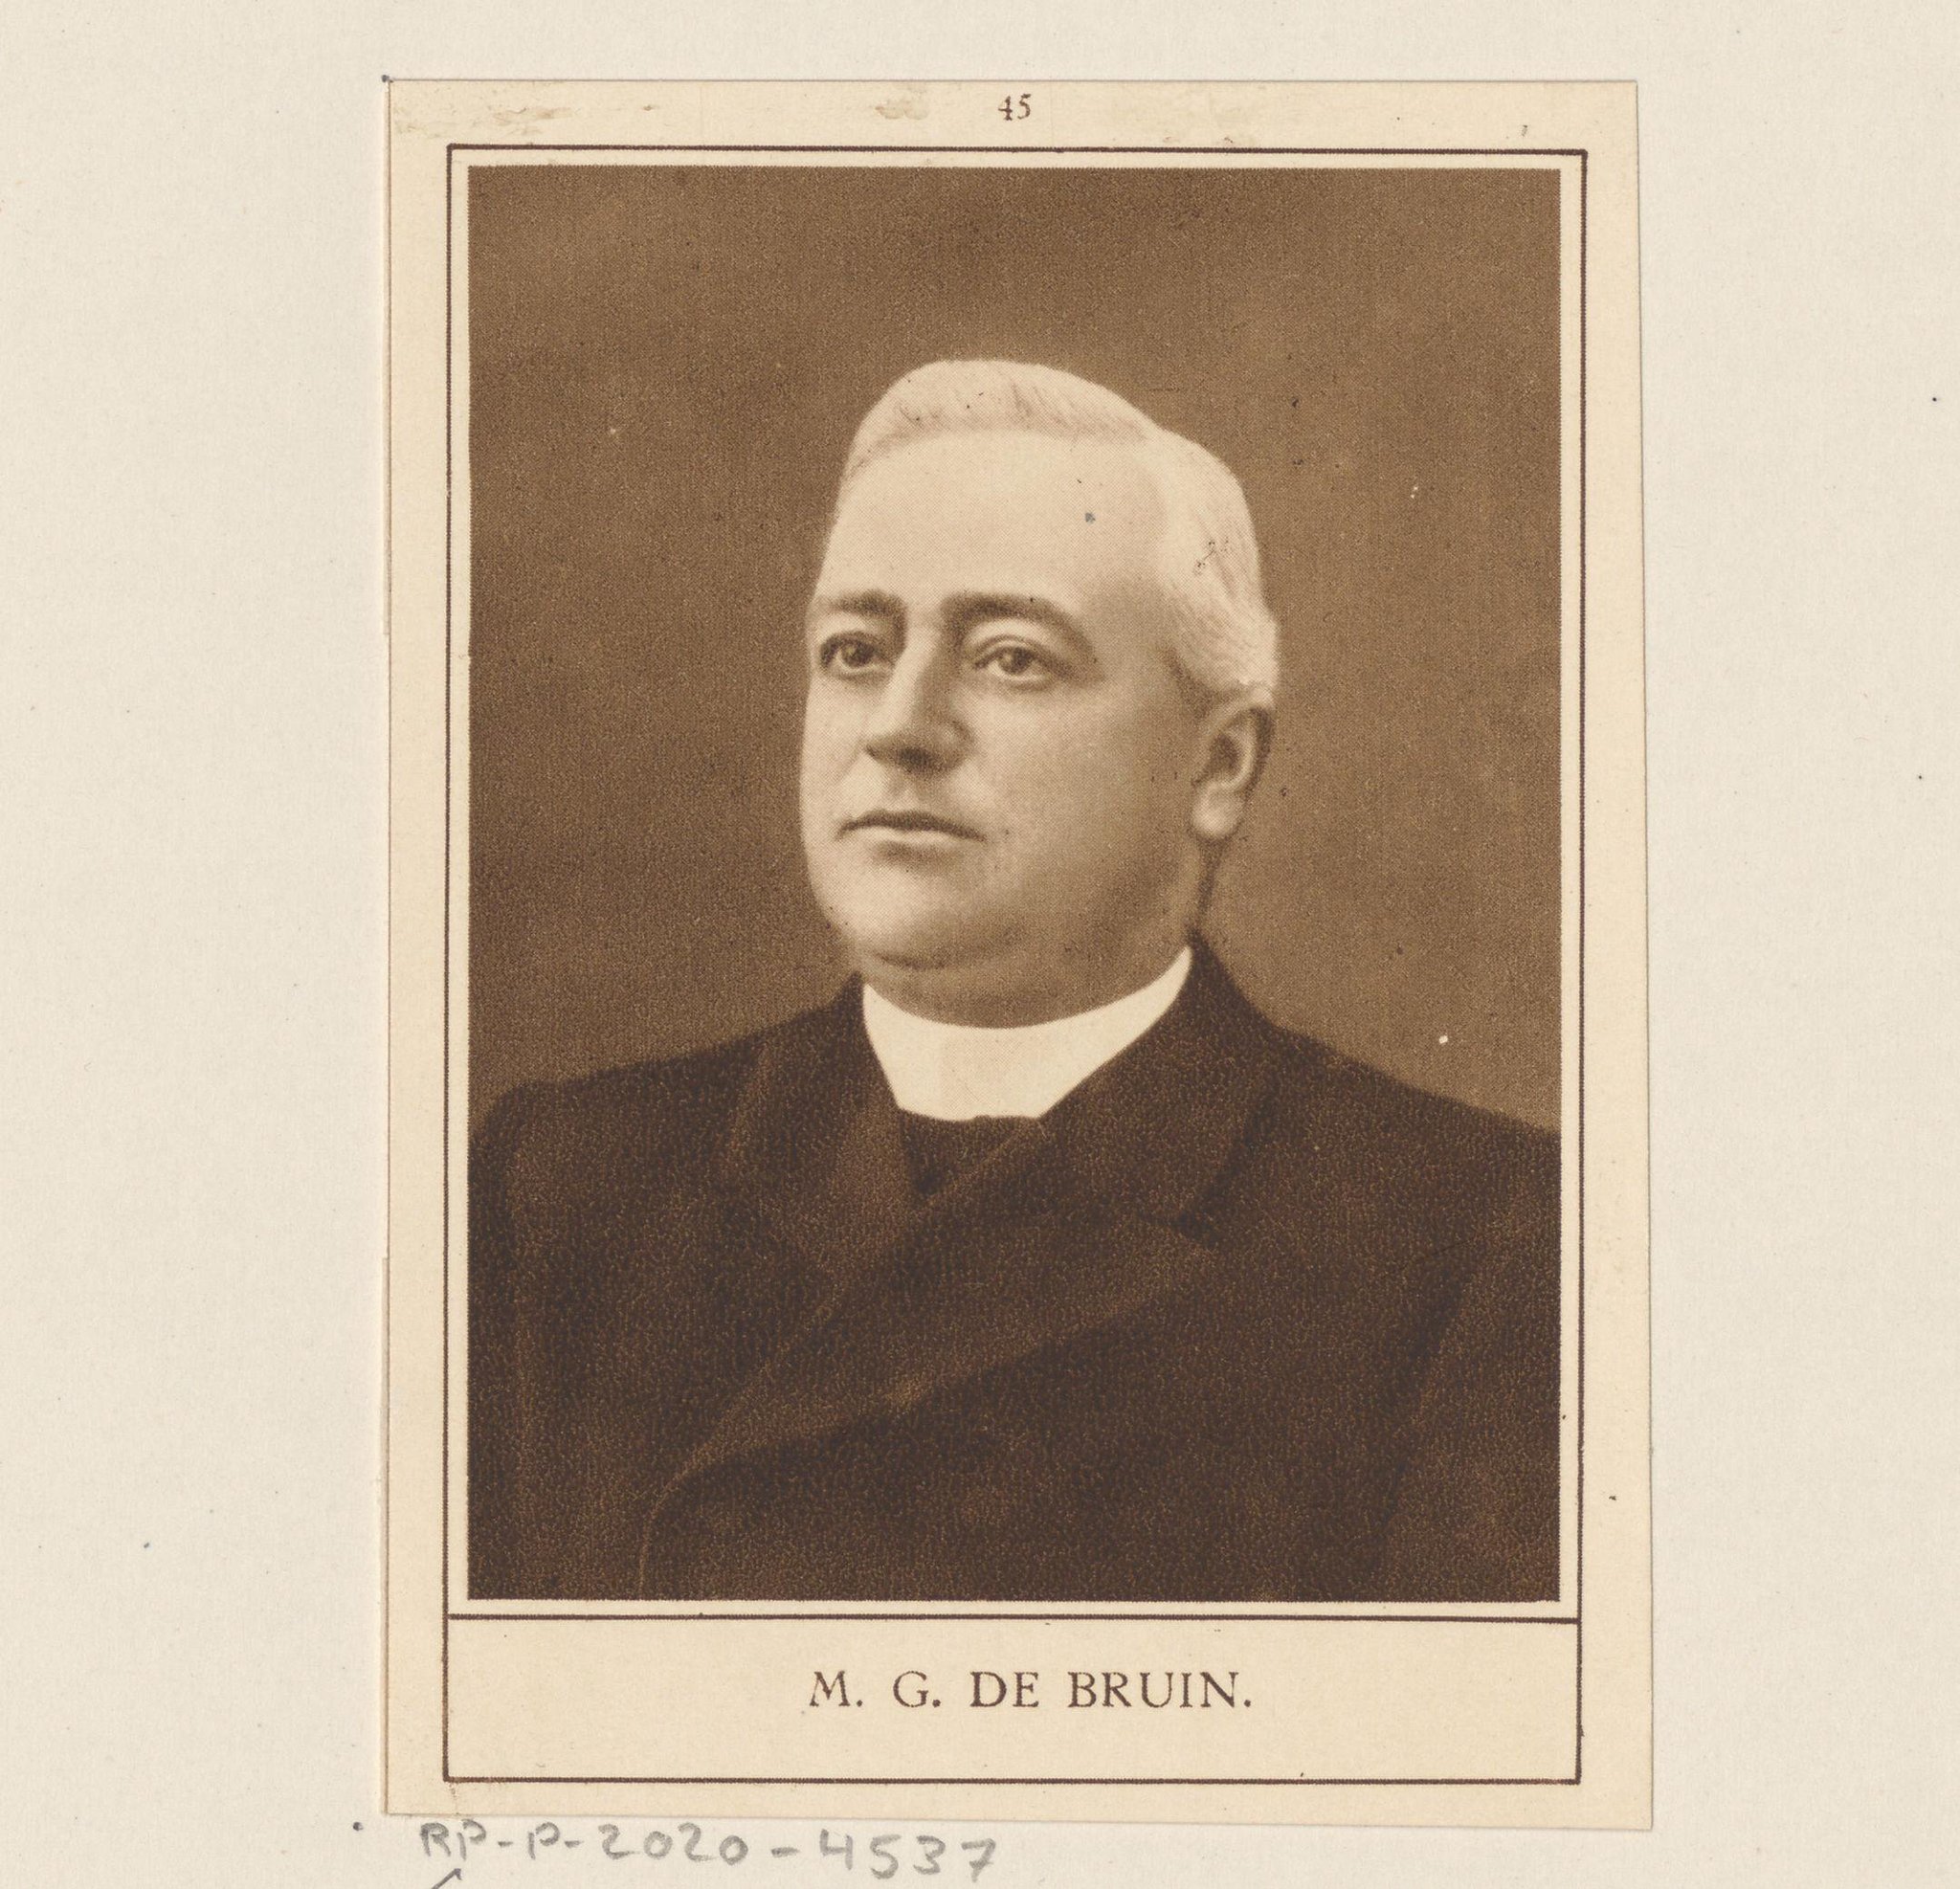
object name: photomechanical print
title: Portret van Martinus Gerardus de Bruin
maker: Anonymous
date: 1895-1940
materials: paper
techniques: rotogravure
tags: scholar, philosopher, historical persons